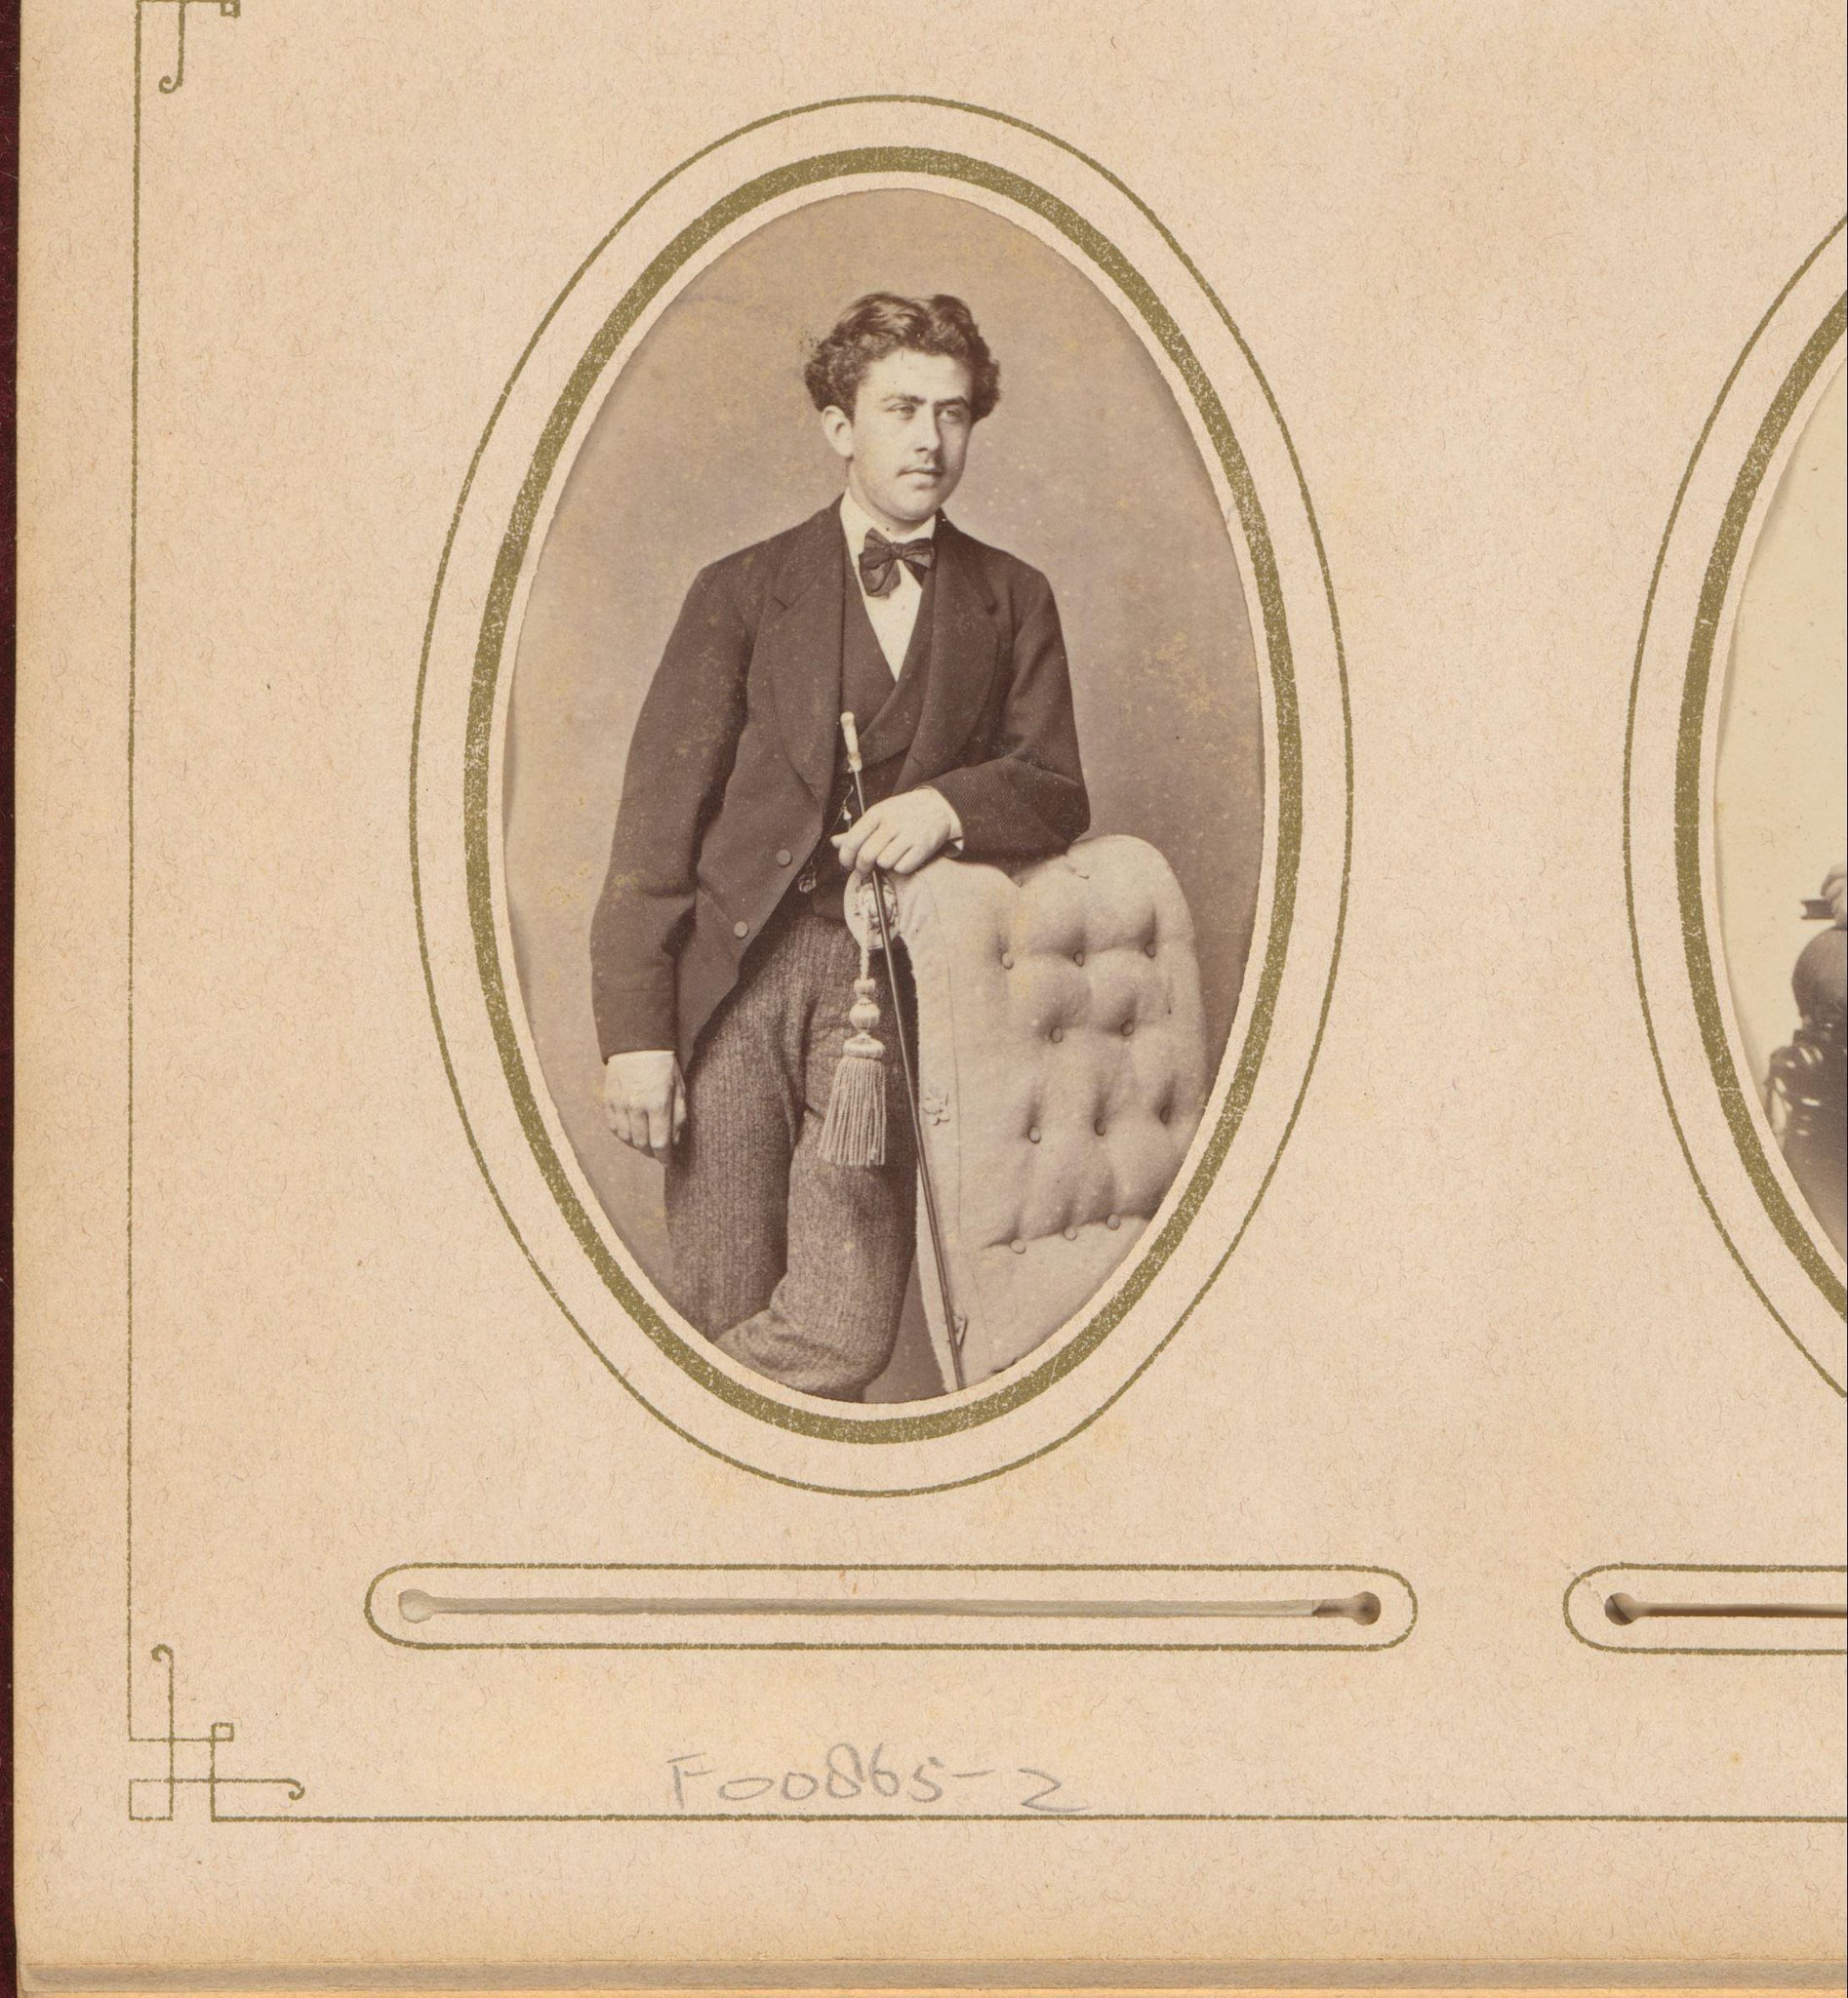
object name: carte de visite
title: Portret van een jonge man met staf in de hand, leunend op de leuning van een stoel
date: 1867-1879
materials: cardboard, photographic support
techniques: albumen print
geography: breda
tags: walking-stick, staff, historical persons, youth, adolescent, chair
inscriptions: inscription: ‘(...)/ KANNEMANS EN ZOON/ Artiste Photographen/ VAN/ Z. M. DEN KONING en H. M. DE KONINGIN/ BREDA/ Groote Markt/ D. 15/ tegen over het Stadhuis.’